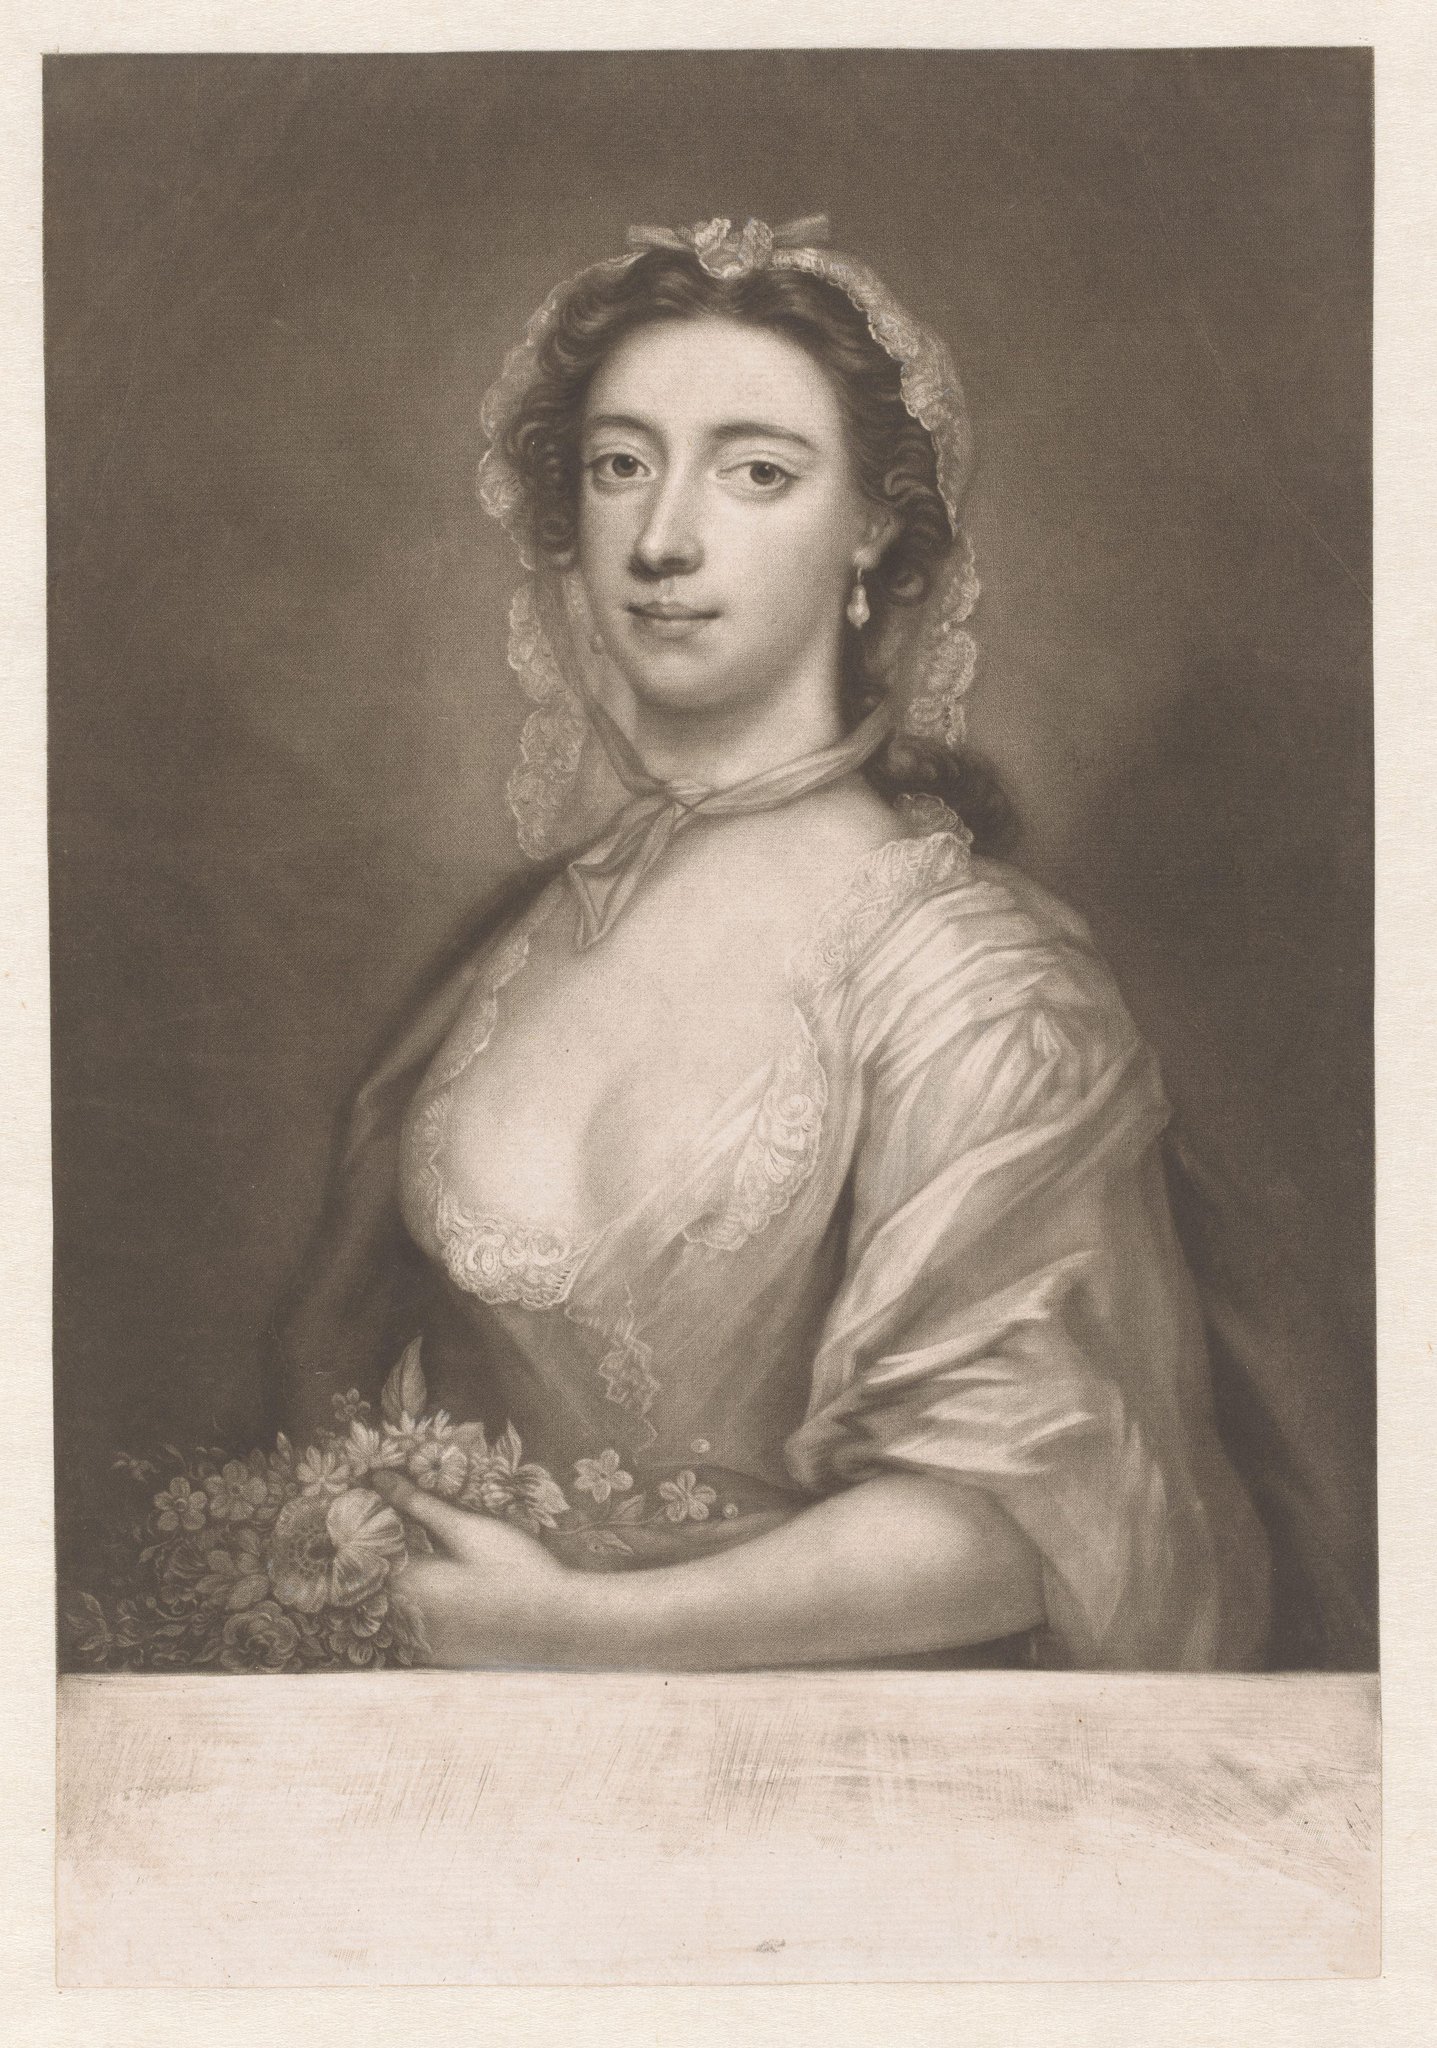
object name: print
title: Portret van Margaret ('Peg') Woffington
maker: james mcardell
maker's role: print maker, publisher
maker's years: 1728-1765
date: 1745-1765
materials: paper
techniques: mezzotint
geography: london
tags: historical persons - bb - woman, portrait of actor, actress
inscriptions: collector's mark: Lugt 240